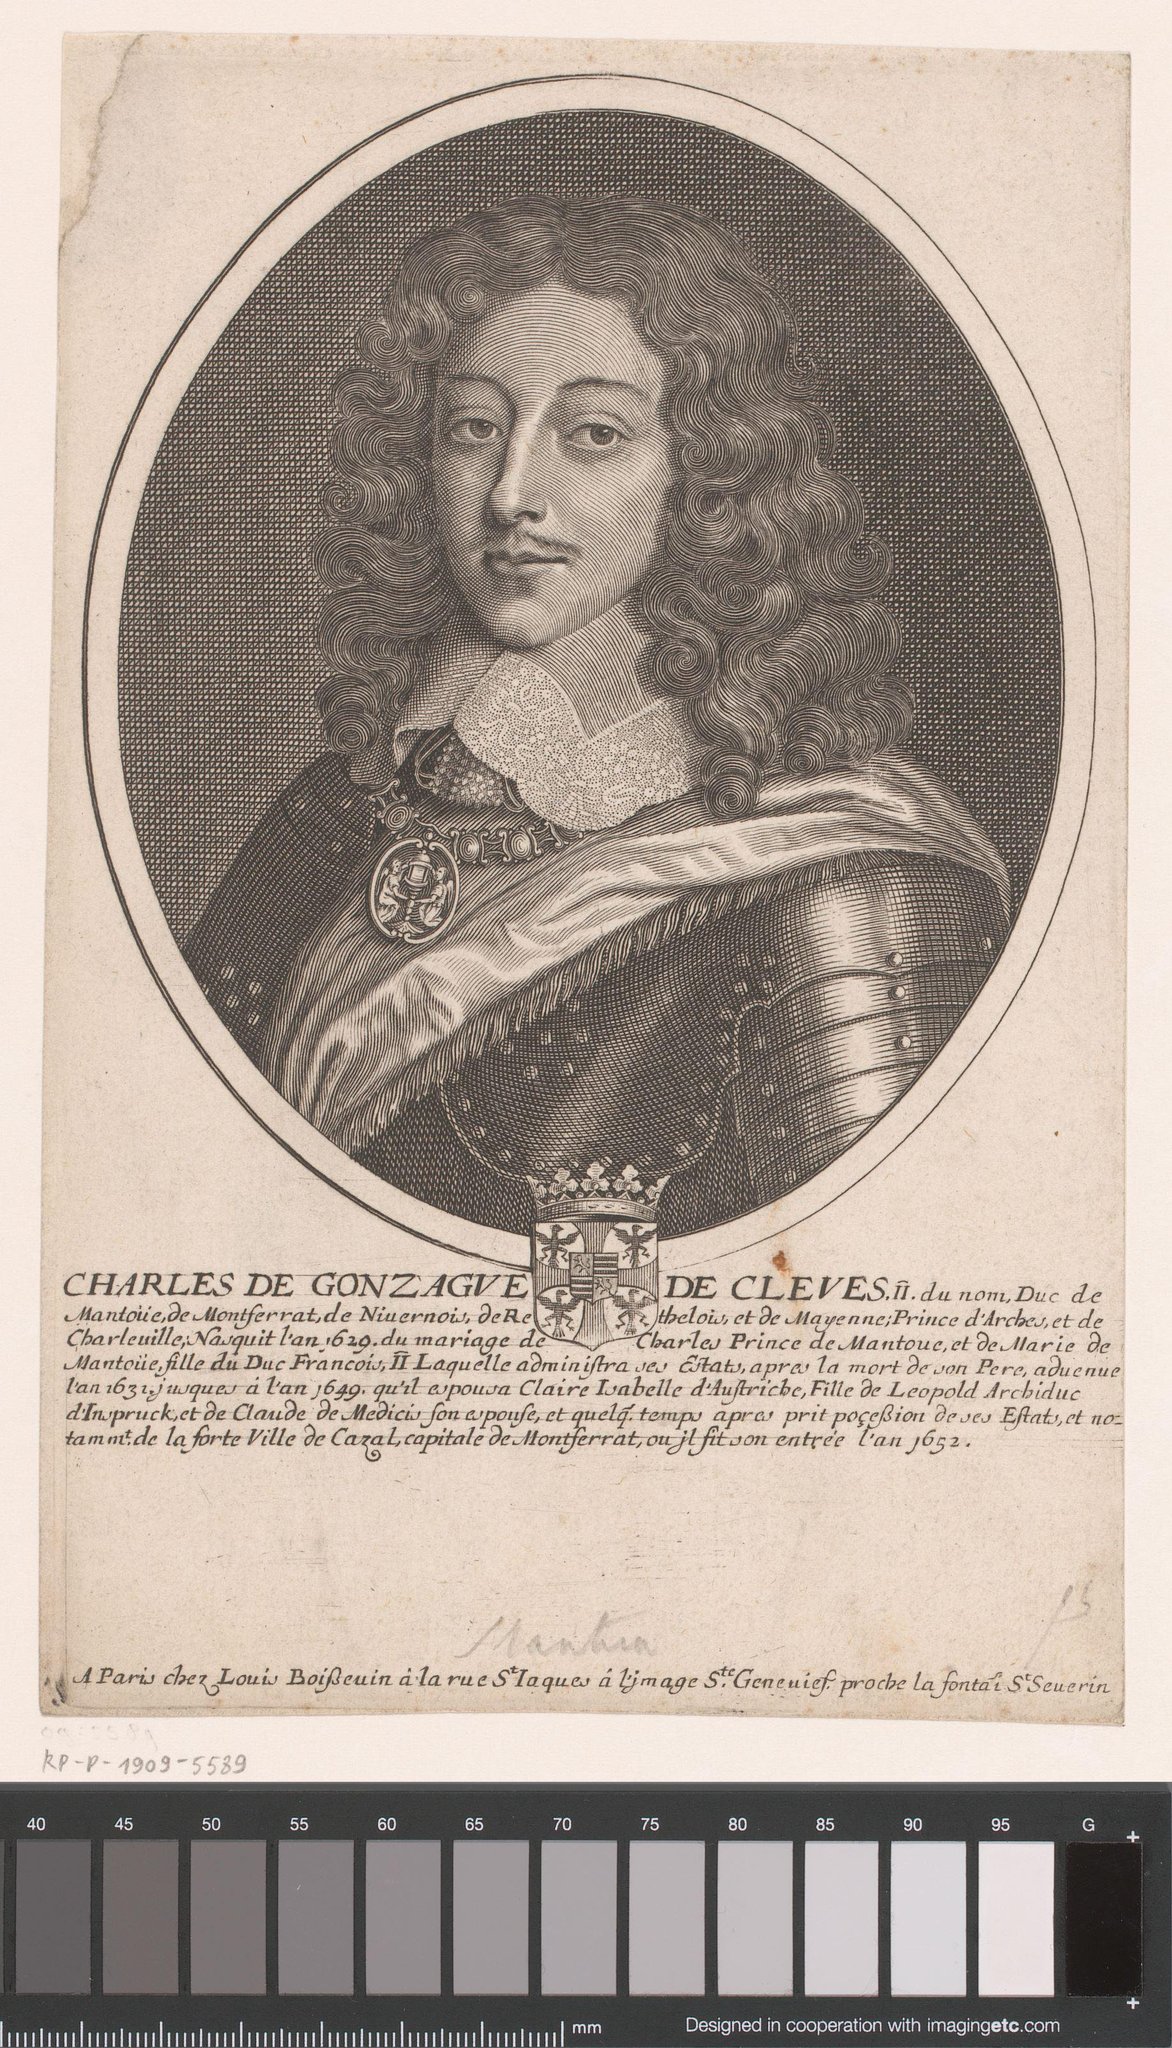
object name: print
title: Charles de Gonzague de Cleves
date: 1652-1676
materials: paper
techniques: engraving, etching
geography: paris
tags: ornament ~ medallion, historical persons, armorial bearing, heraldry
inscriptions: collector's mark: Lugt 2228